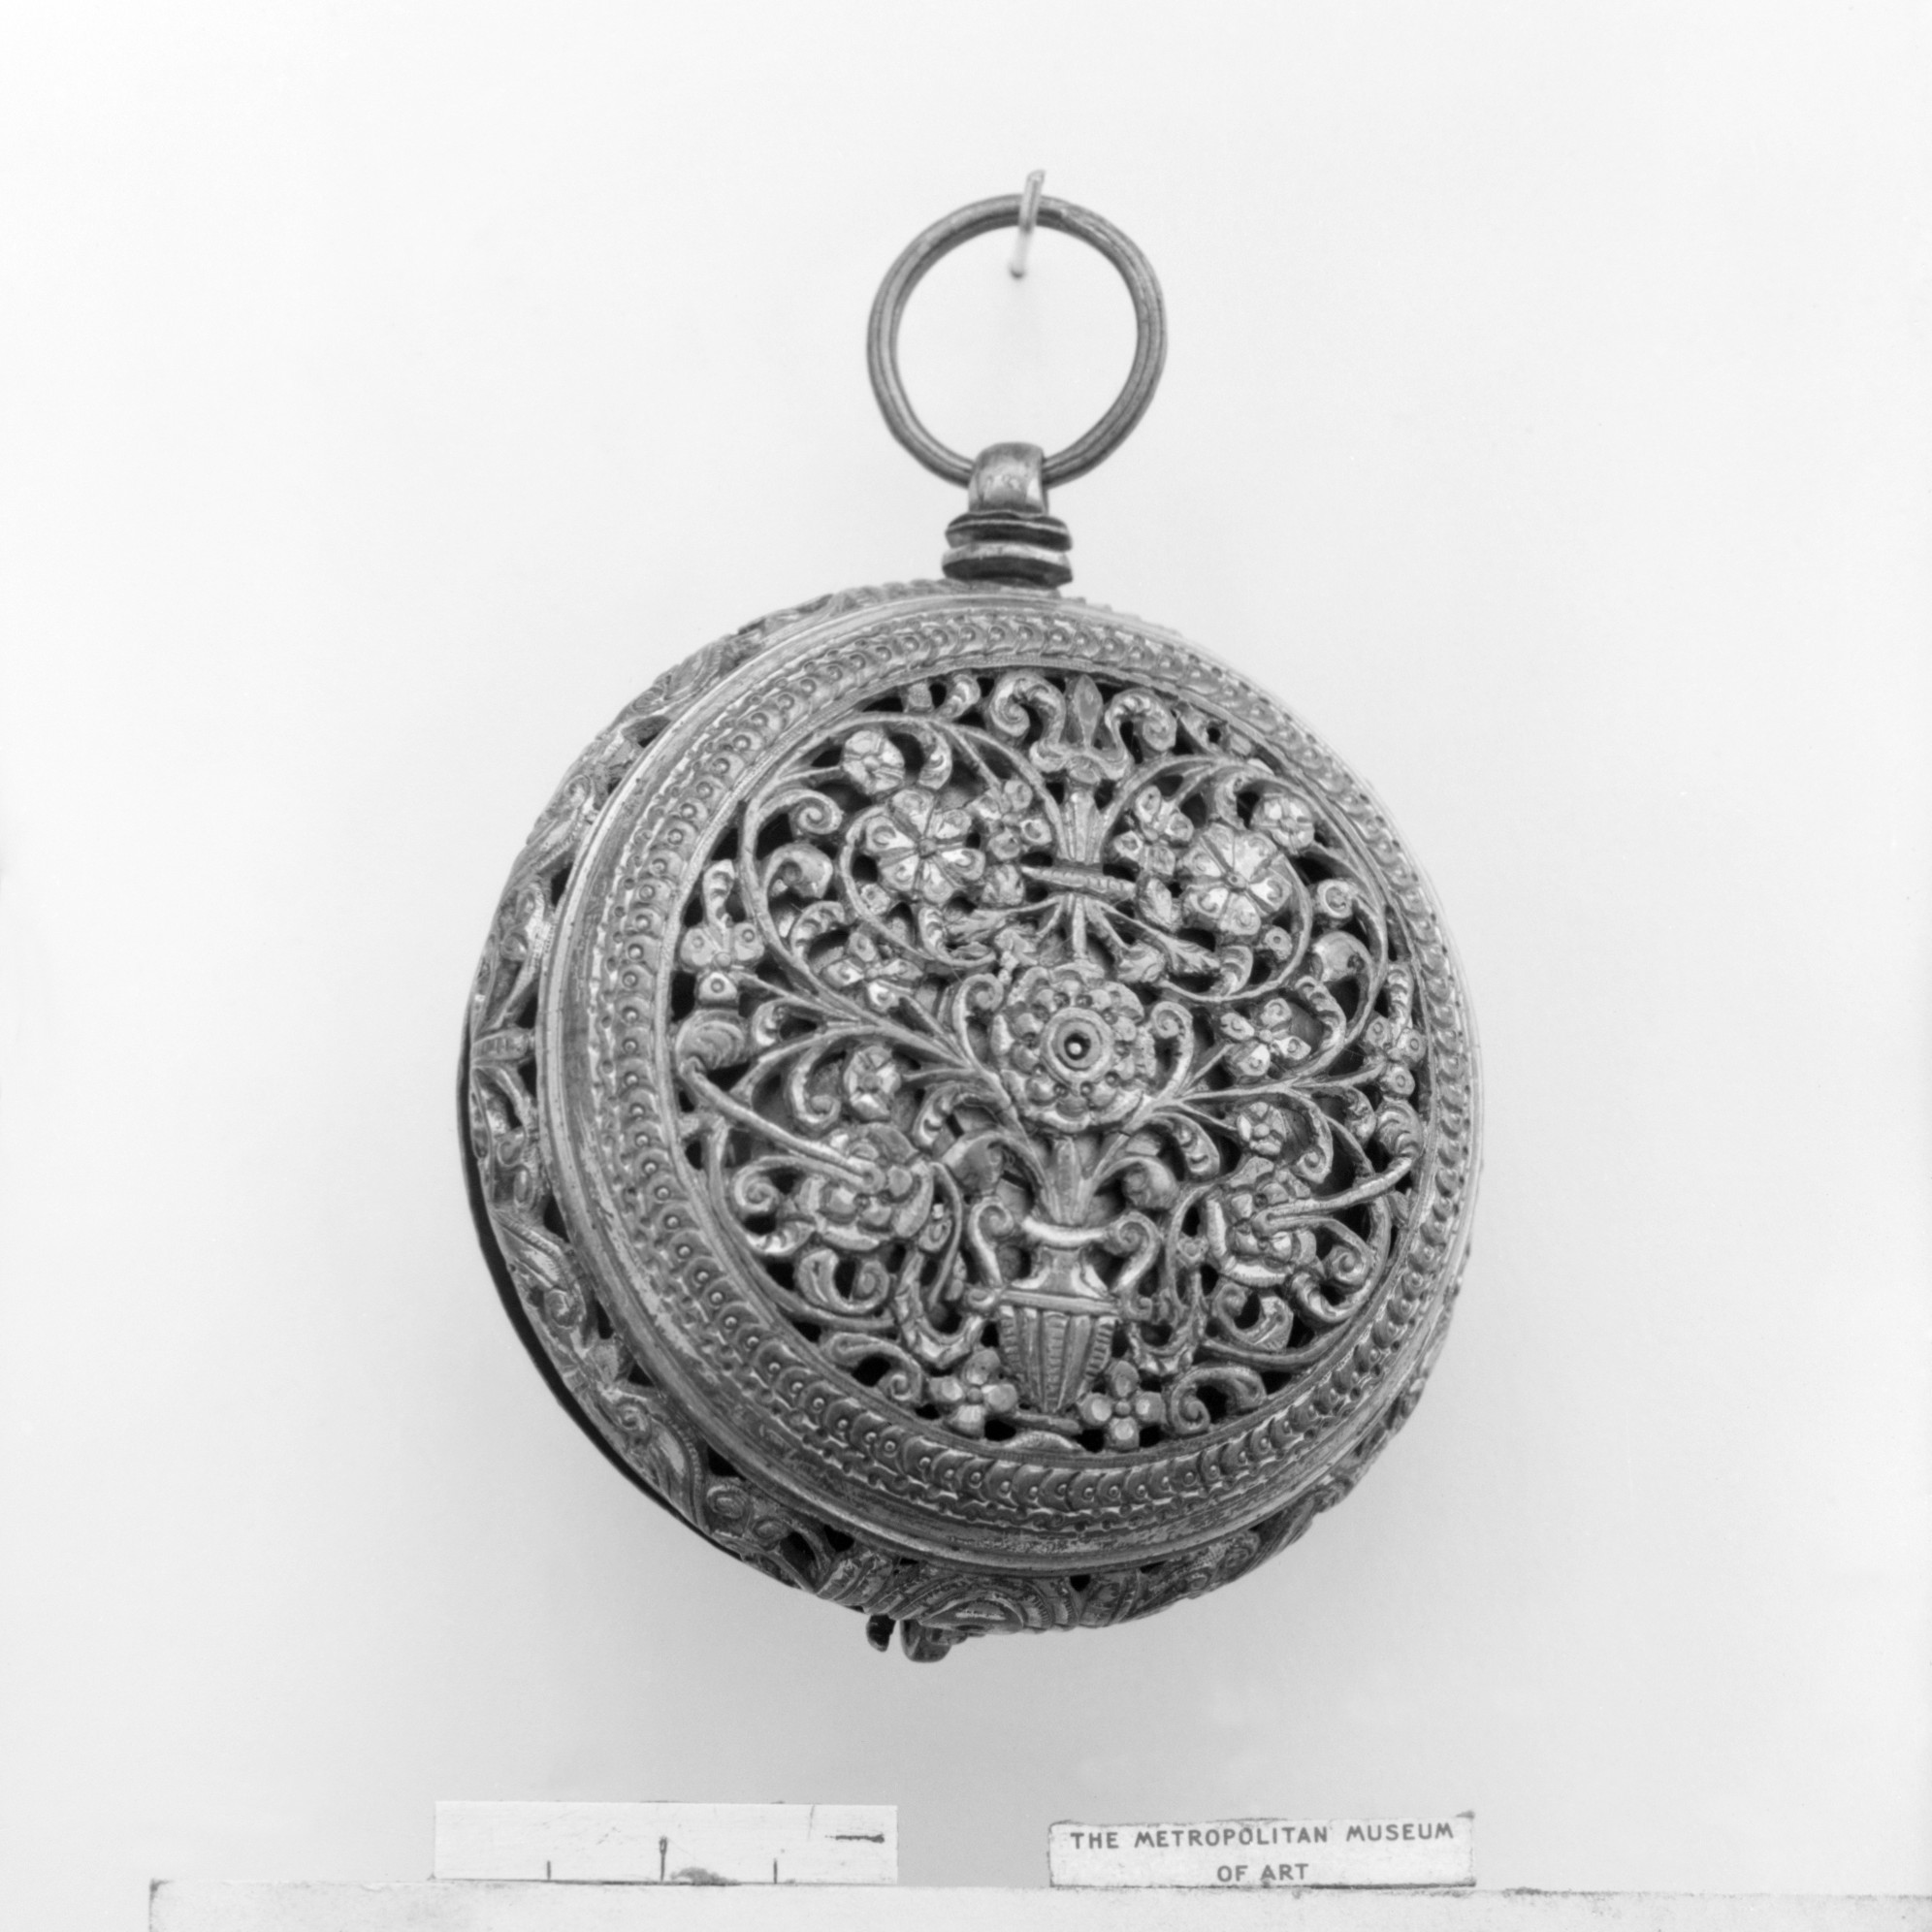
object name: alarm watch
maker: baptiste le noir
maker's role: maker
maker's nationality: french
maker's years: 1734-1819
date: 1760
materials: enamel, gilt, metal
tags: flowers